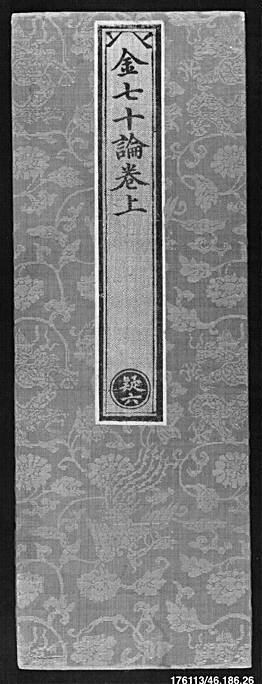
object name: sutra cover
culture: chinese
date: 1501-1600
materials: silk